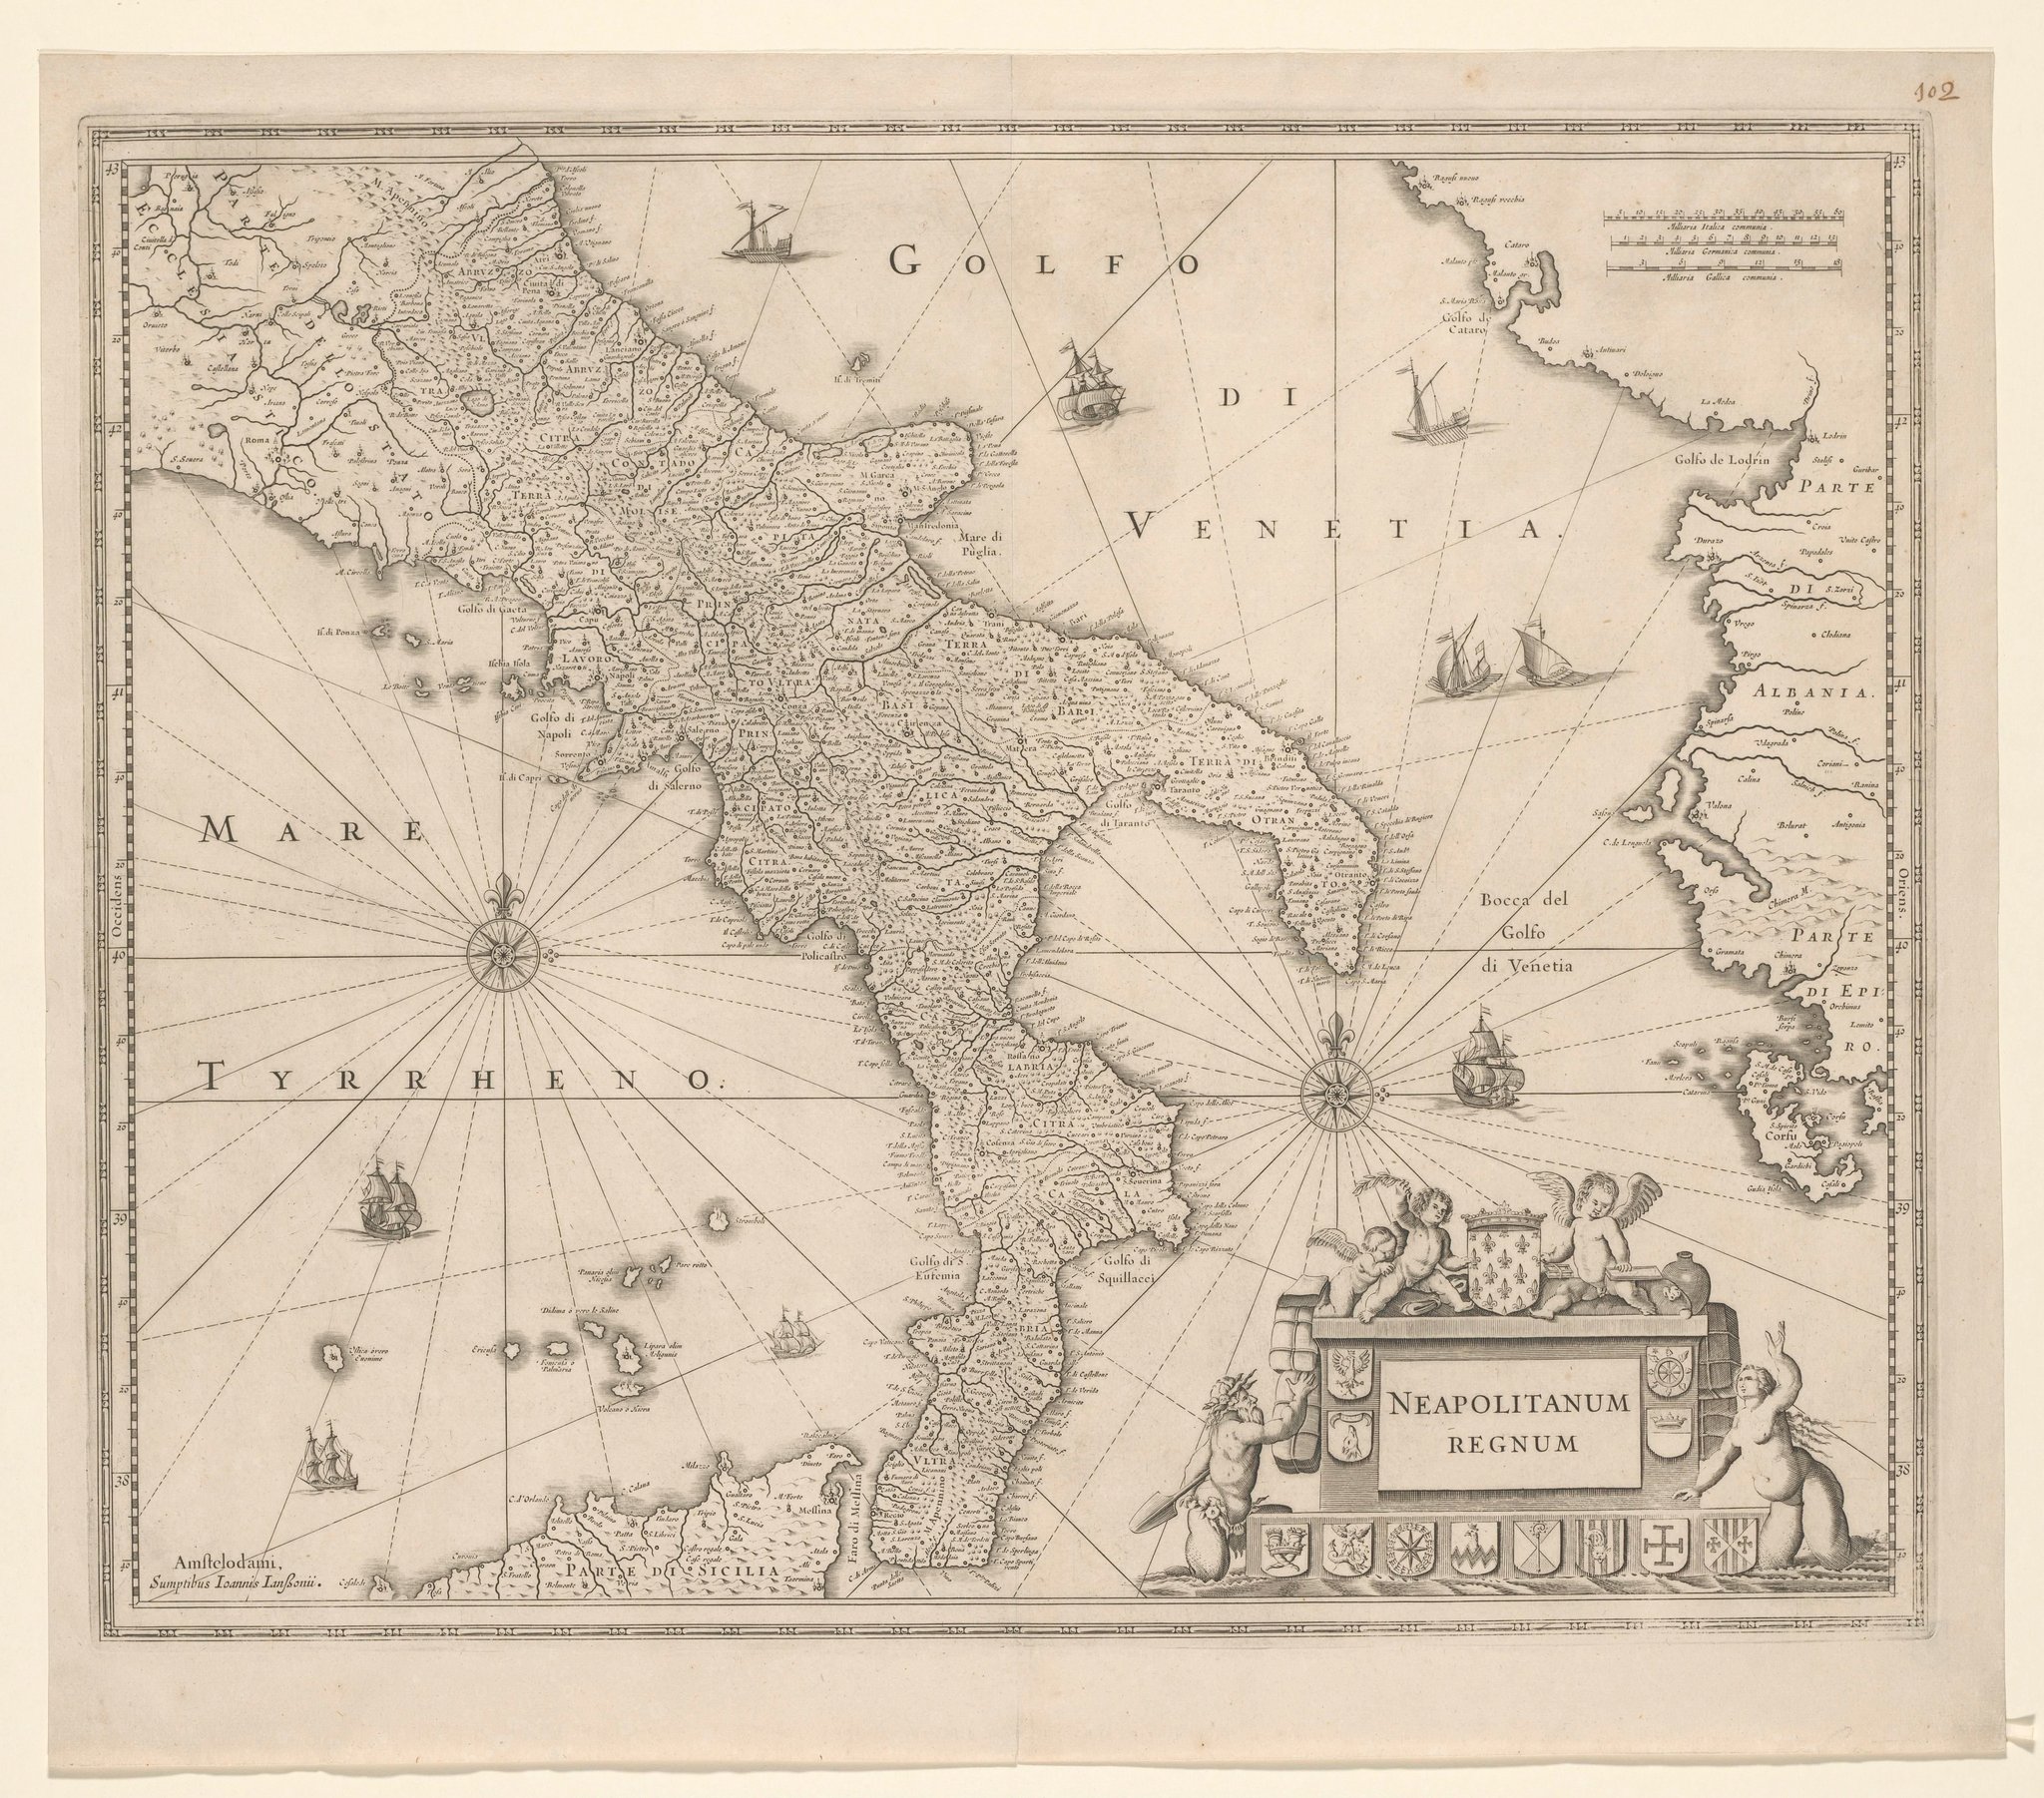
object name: print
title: Kaart van het Koninkrijk Napels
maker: Anonymous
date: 1633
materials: paper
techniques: engraving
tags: coat of arms (as symbol of the state, etc.) (+ city; municipal), maps of separate countries or regions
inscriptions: collector's mark: Lugt 2228, collector's mark: ‘F’